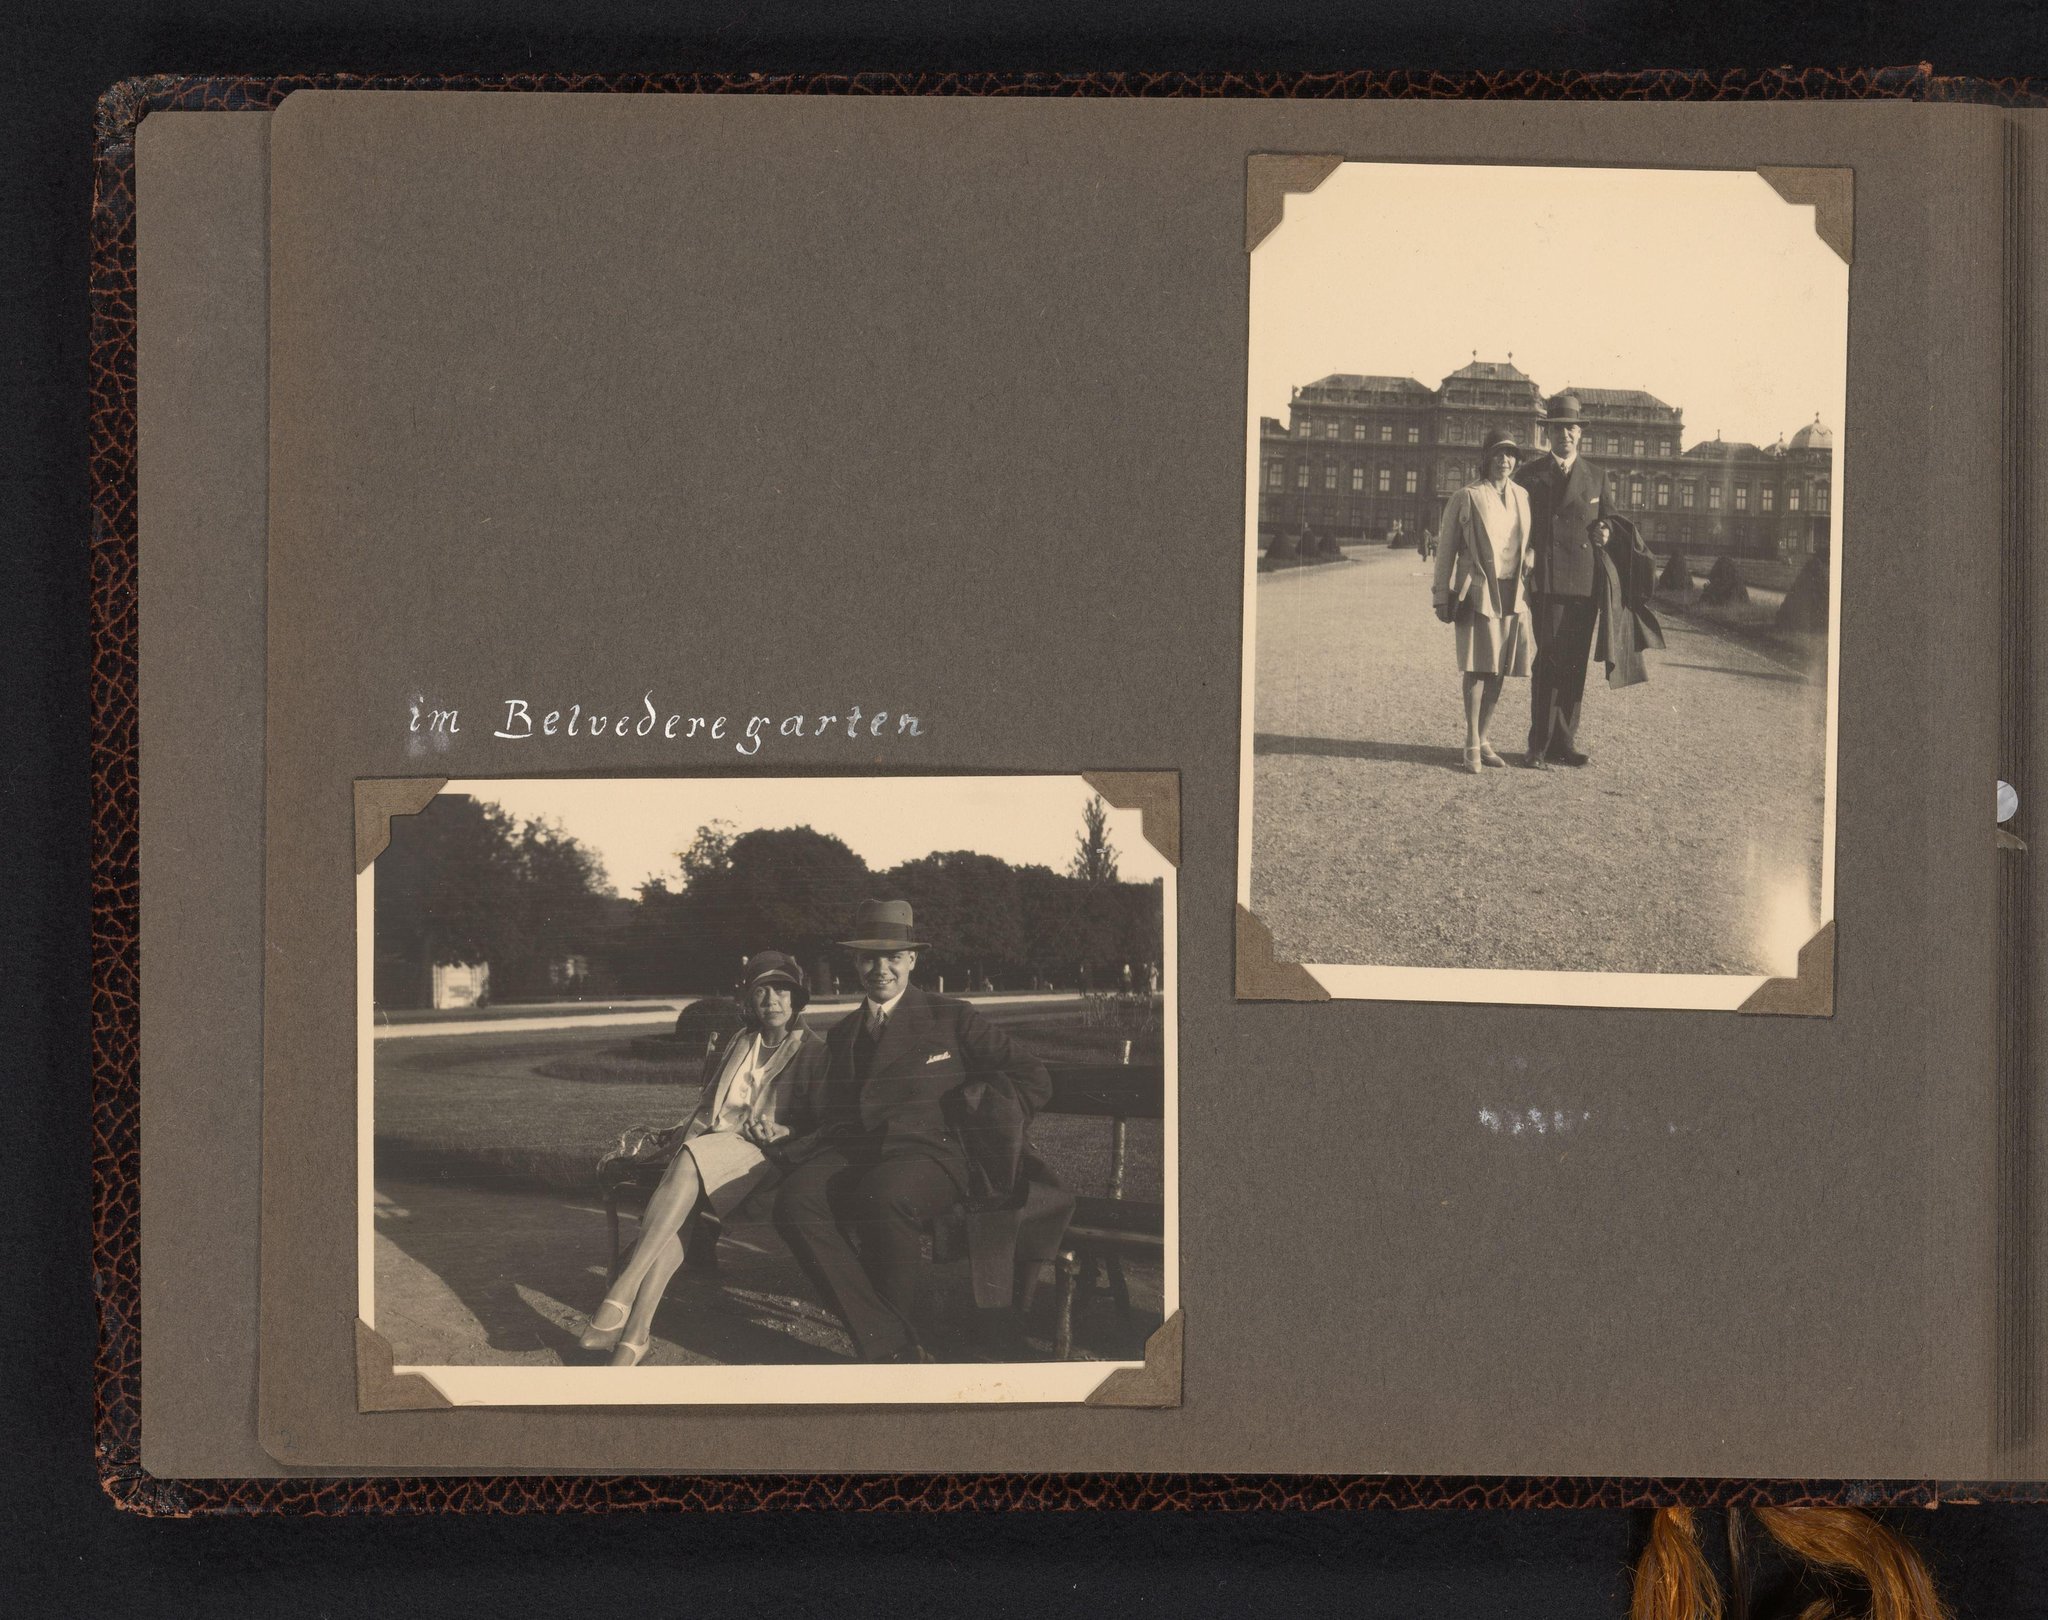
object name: photograph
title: Echtpaar Berti Hoppe en Herman Besselaar bij het Slot Belvedere te Wenen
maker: Anonymous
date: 1930-1931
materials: cardboard, paper, photographic support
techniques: gelatin silver print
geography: vienna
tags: herman besselaar, berti hoppe, historical persons - bb - woman, historical persons, palace, vienna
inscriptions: annotation: ‘im Belvederegarten’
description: Twee foto's gemaakt tijdens hun verlovingsreis naar Wenen en Boedapest. Deze pagina maakt deel uit van een album.